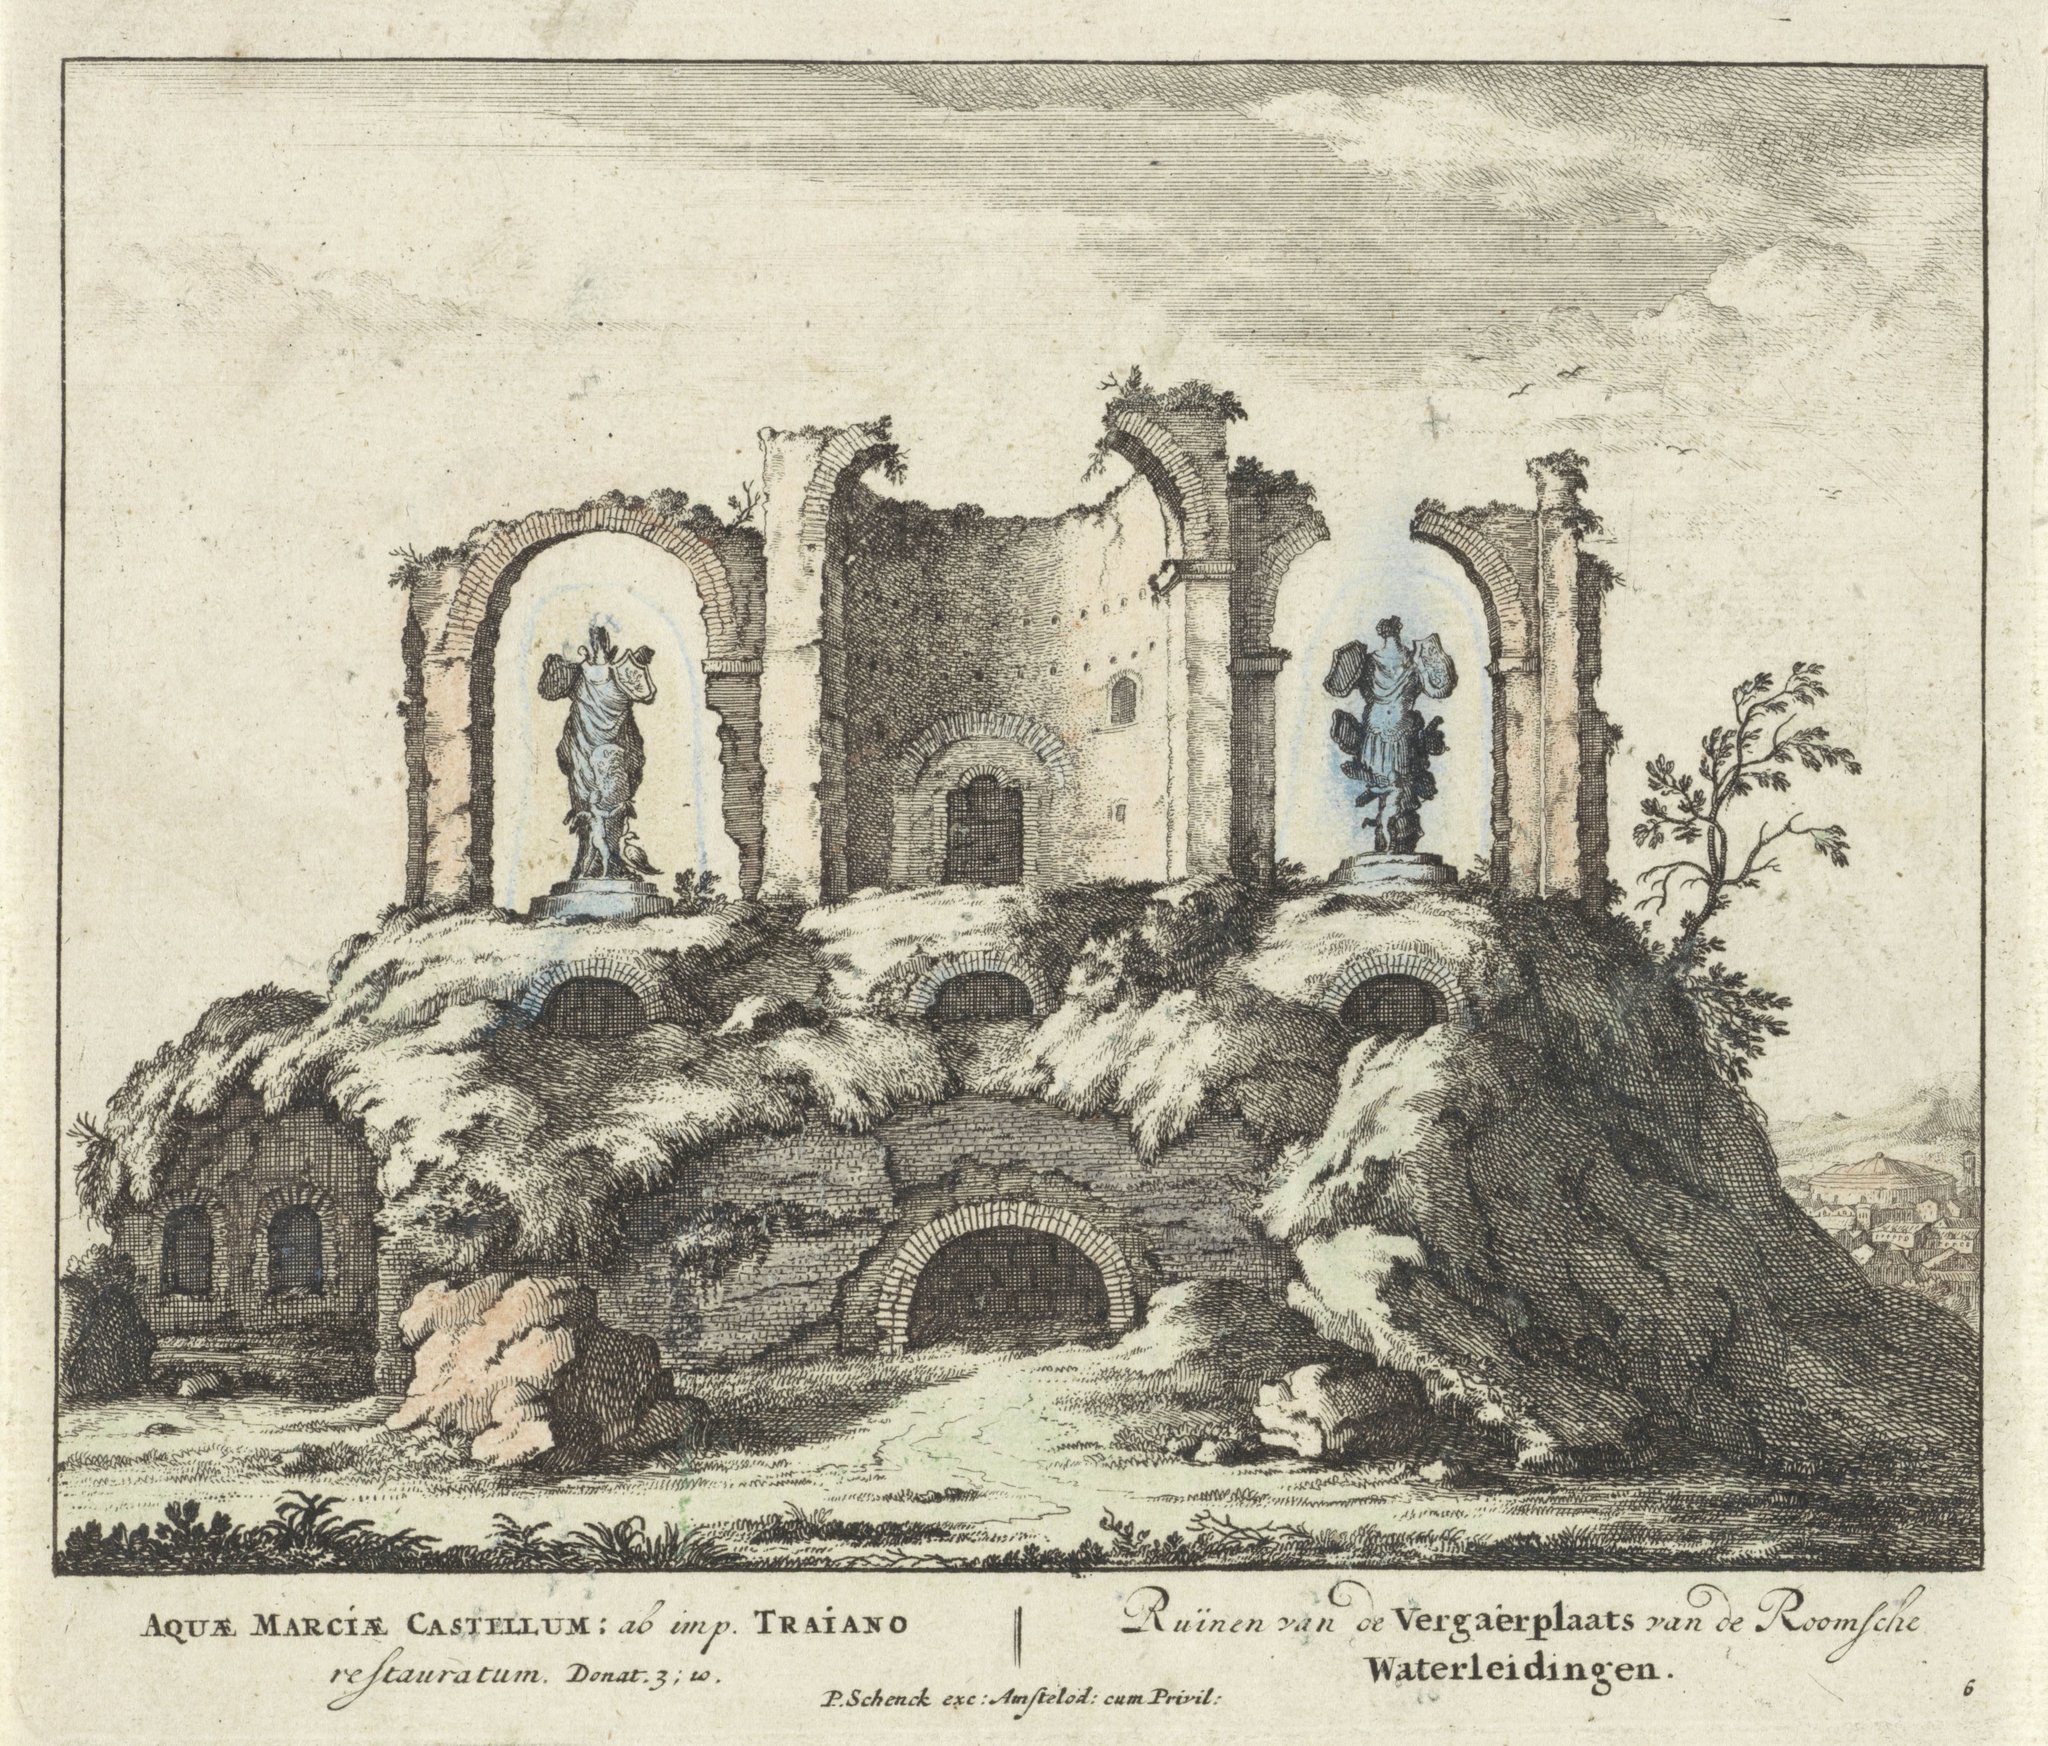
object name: print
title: Gezichten in Rome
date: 1675-1711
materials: paper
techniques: etching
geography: amsterdam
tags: landscape with ruins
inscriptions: collector's mark: Lugt 2228